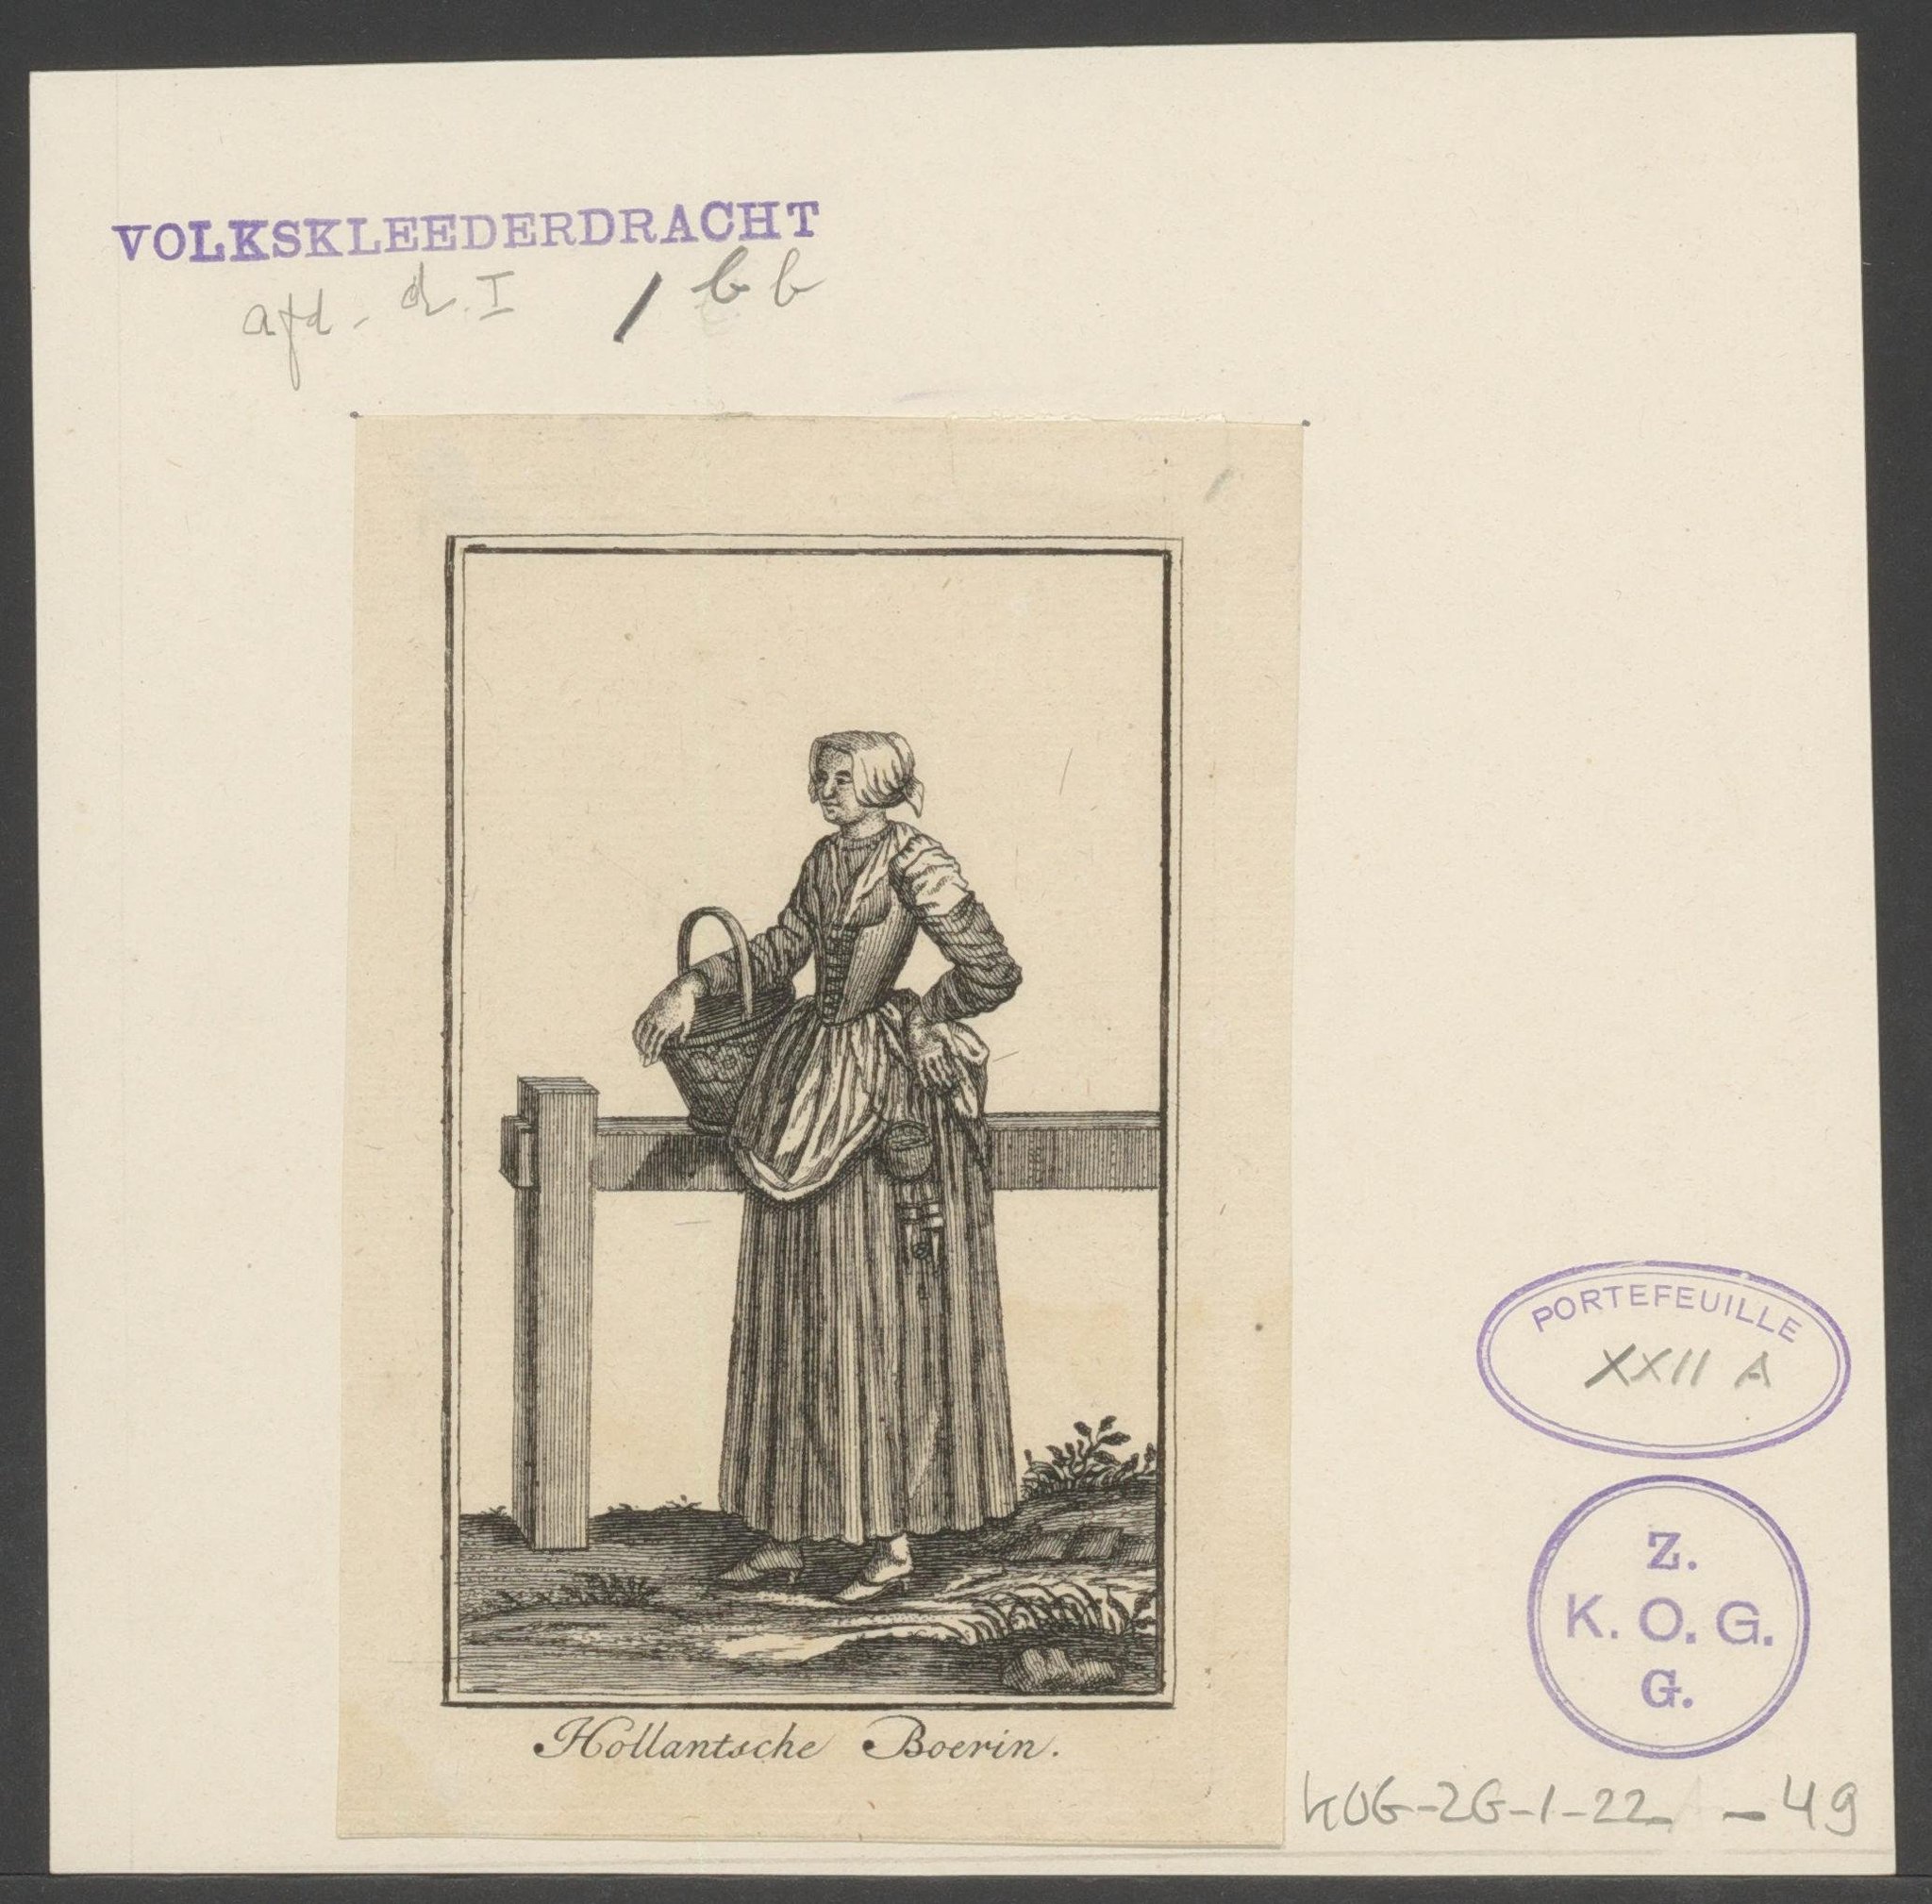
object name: print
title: Hollantsche Boerin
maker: Anonymous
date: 1750-1850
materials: paper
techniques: etching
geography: netherlands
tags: farmers - aa - female farmer, farmer's wife, folk costume, regional costume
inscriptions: collector's mark: Lugt 1641, collector's mark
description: Staande vrouw, een Hollandse boerin, mand aan de arm, bij een hek. Onderwerpsrubrieken binnen de Atlas Zeden en Gewoonten: De Kleeding, Volkskleederdracht.